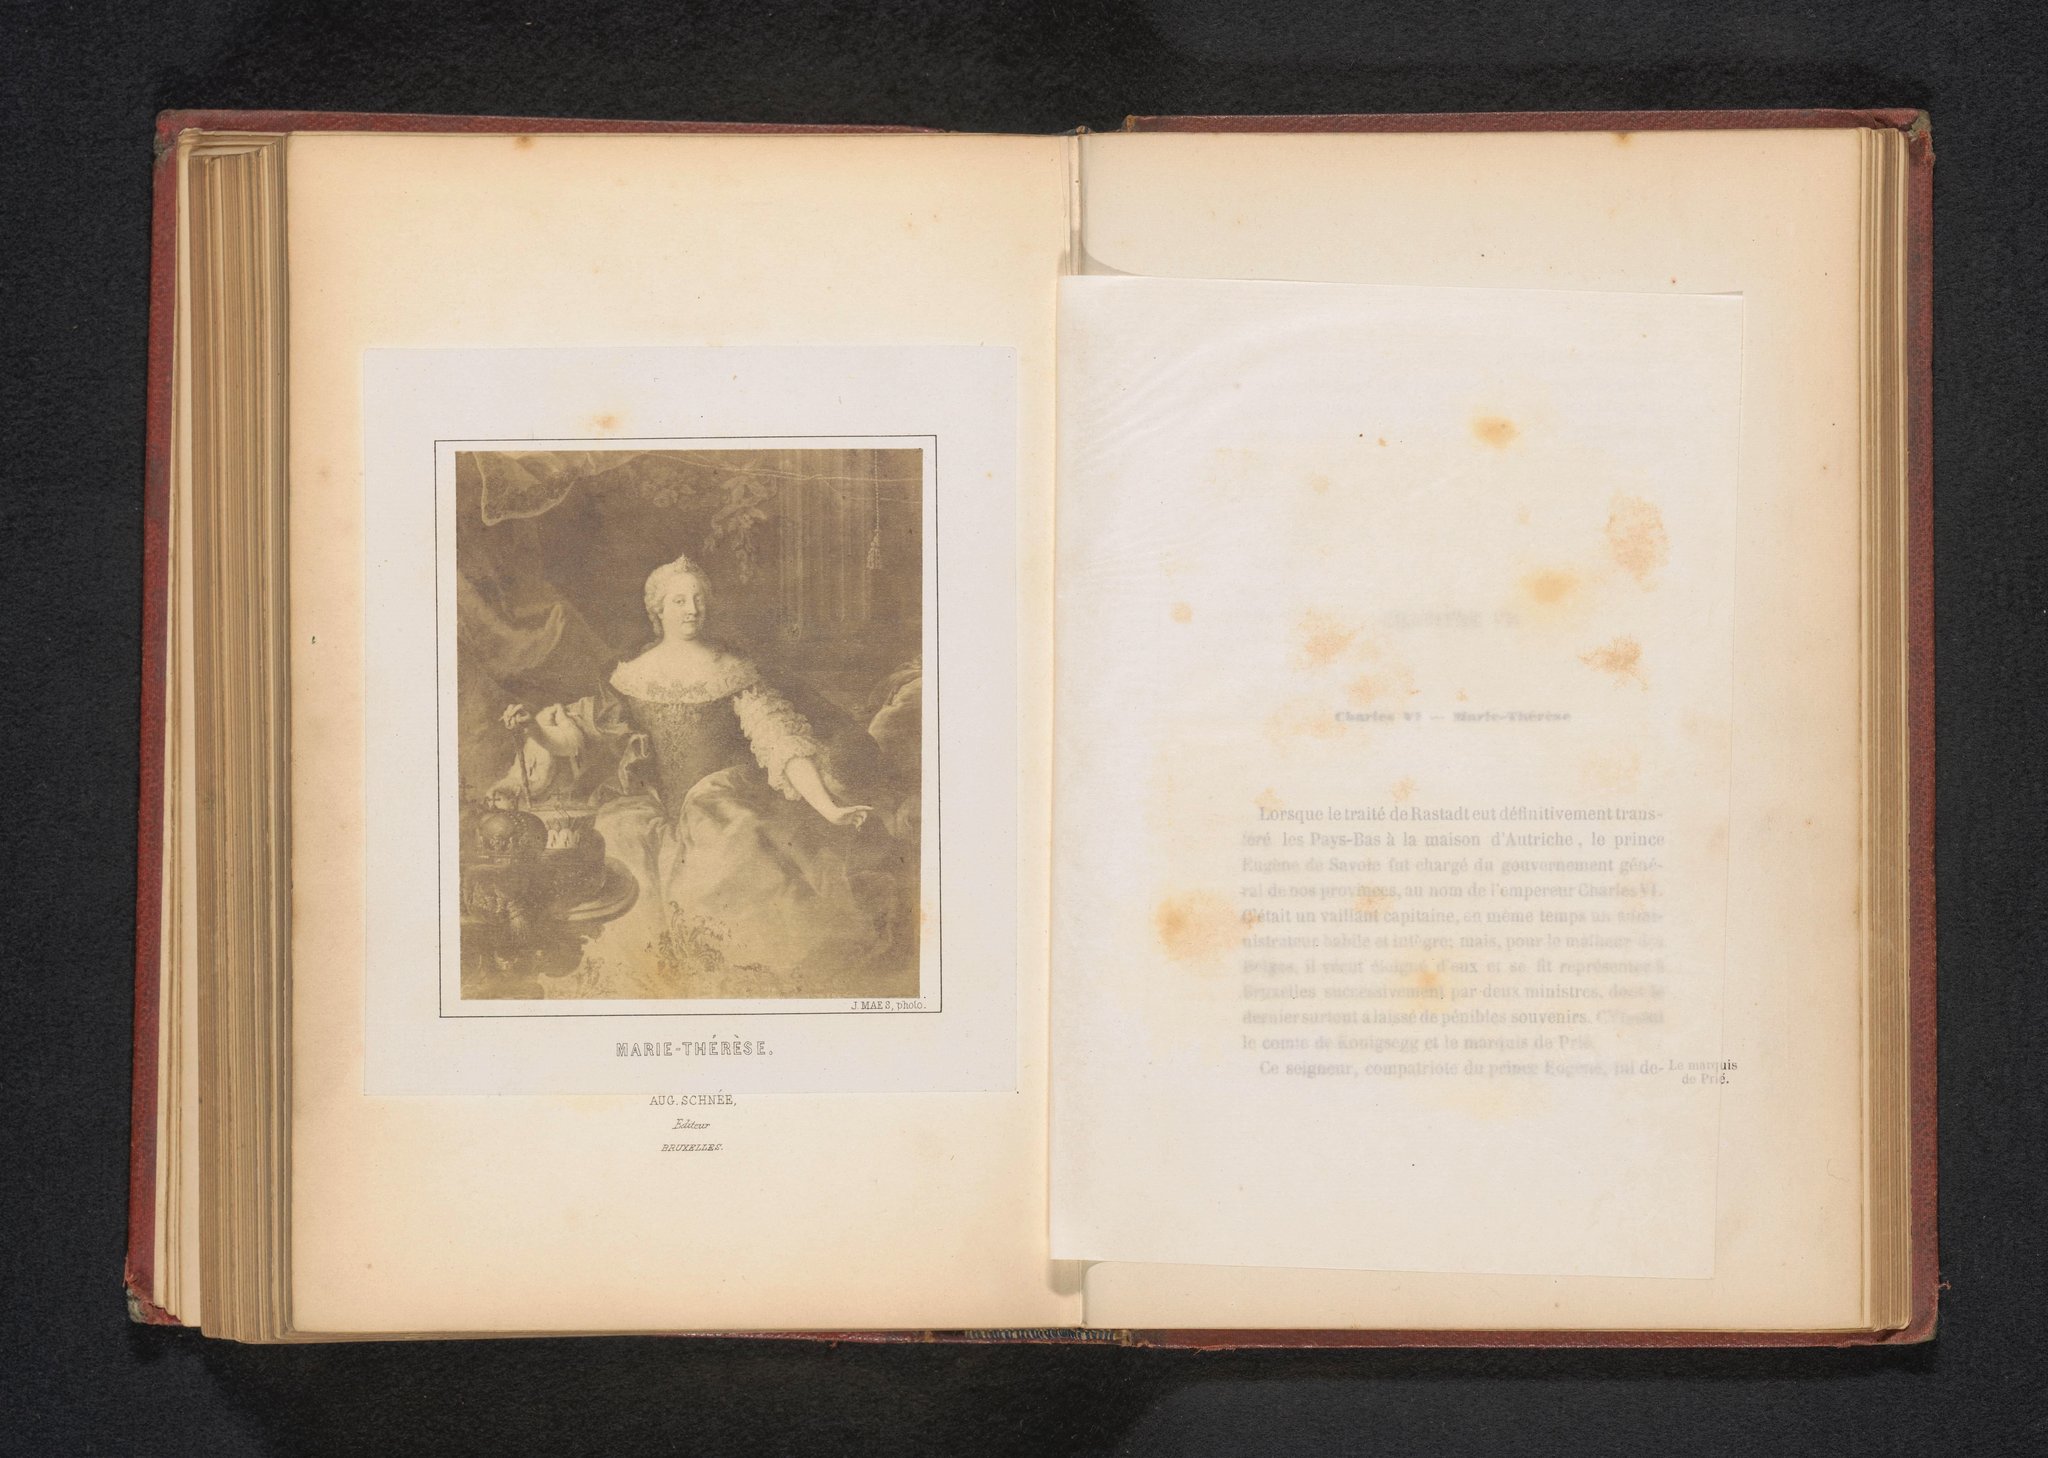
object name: photograph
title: Marie Thérèse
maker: joseph maes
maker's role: fotograaf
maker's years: 1838-1908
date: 1855-1860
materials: photographic support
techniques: albumen print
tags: vienna, maria theresia (rooms-duits keizerin), historical persons - bb - woman